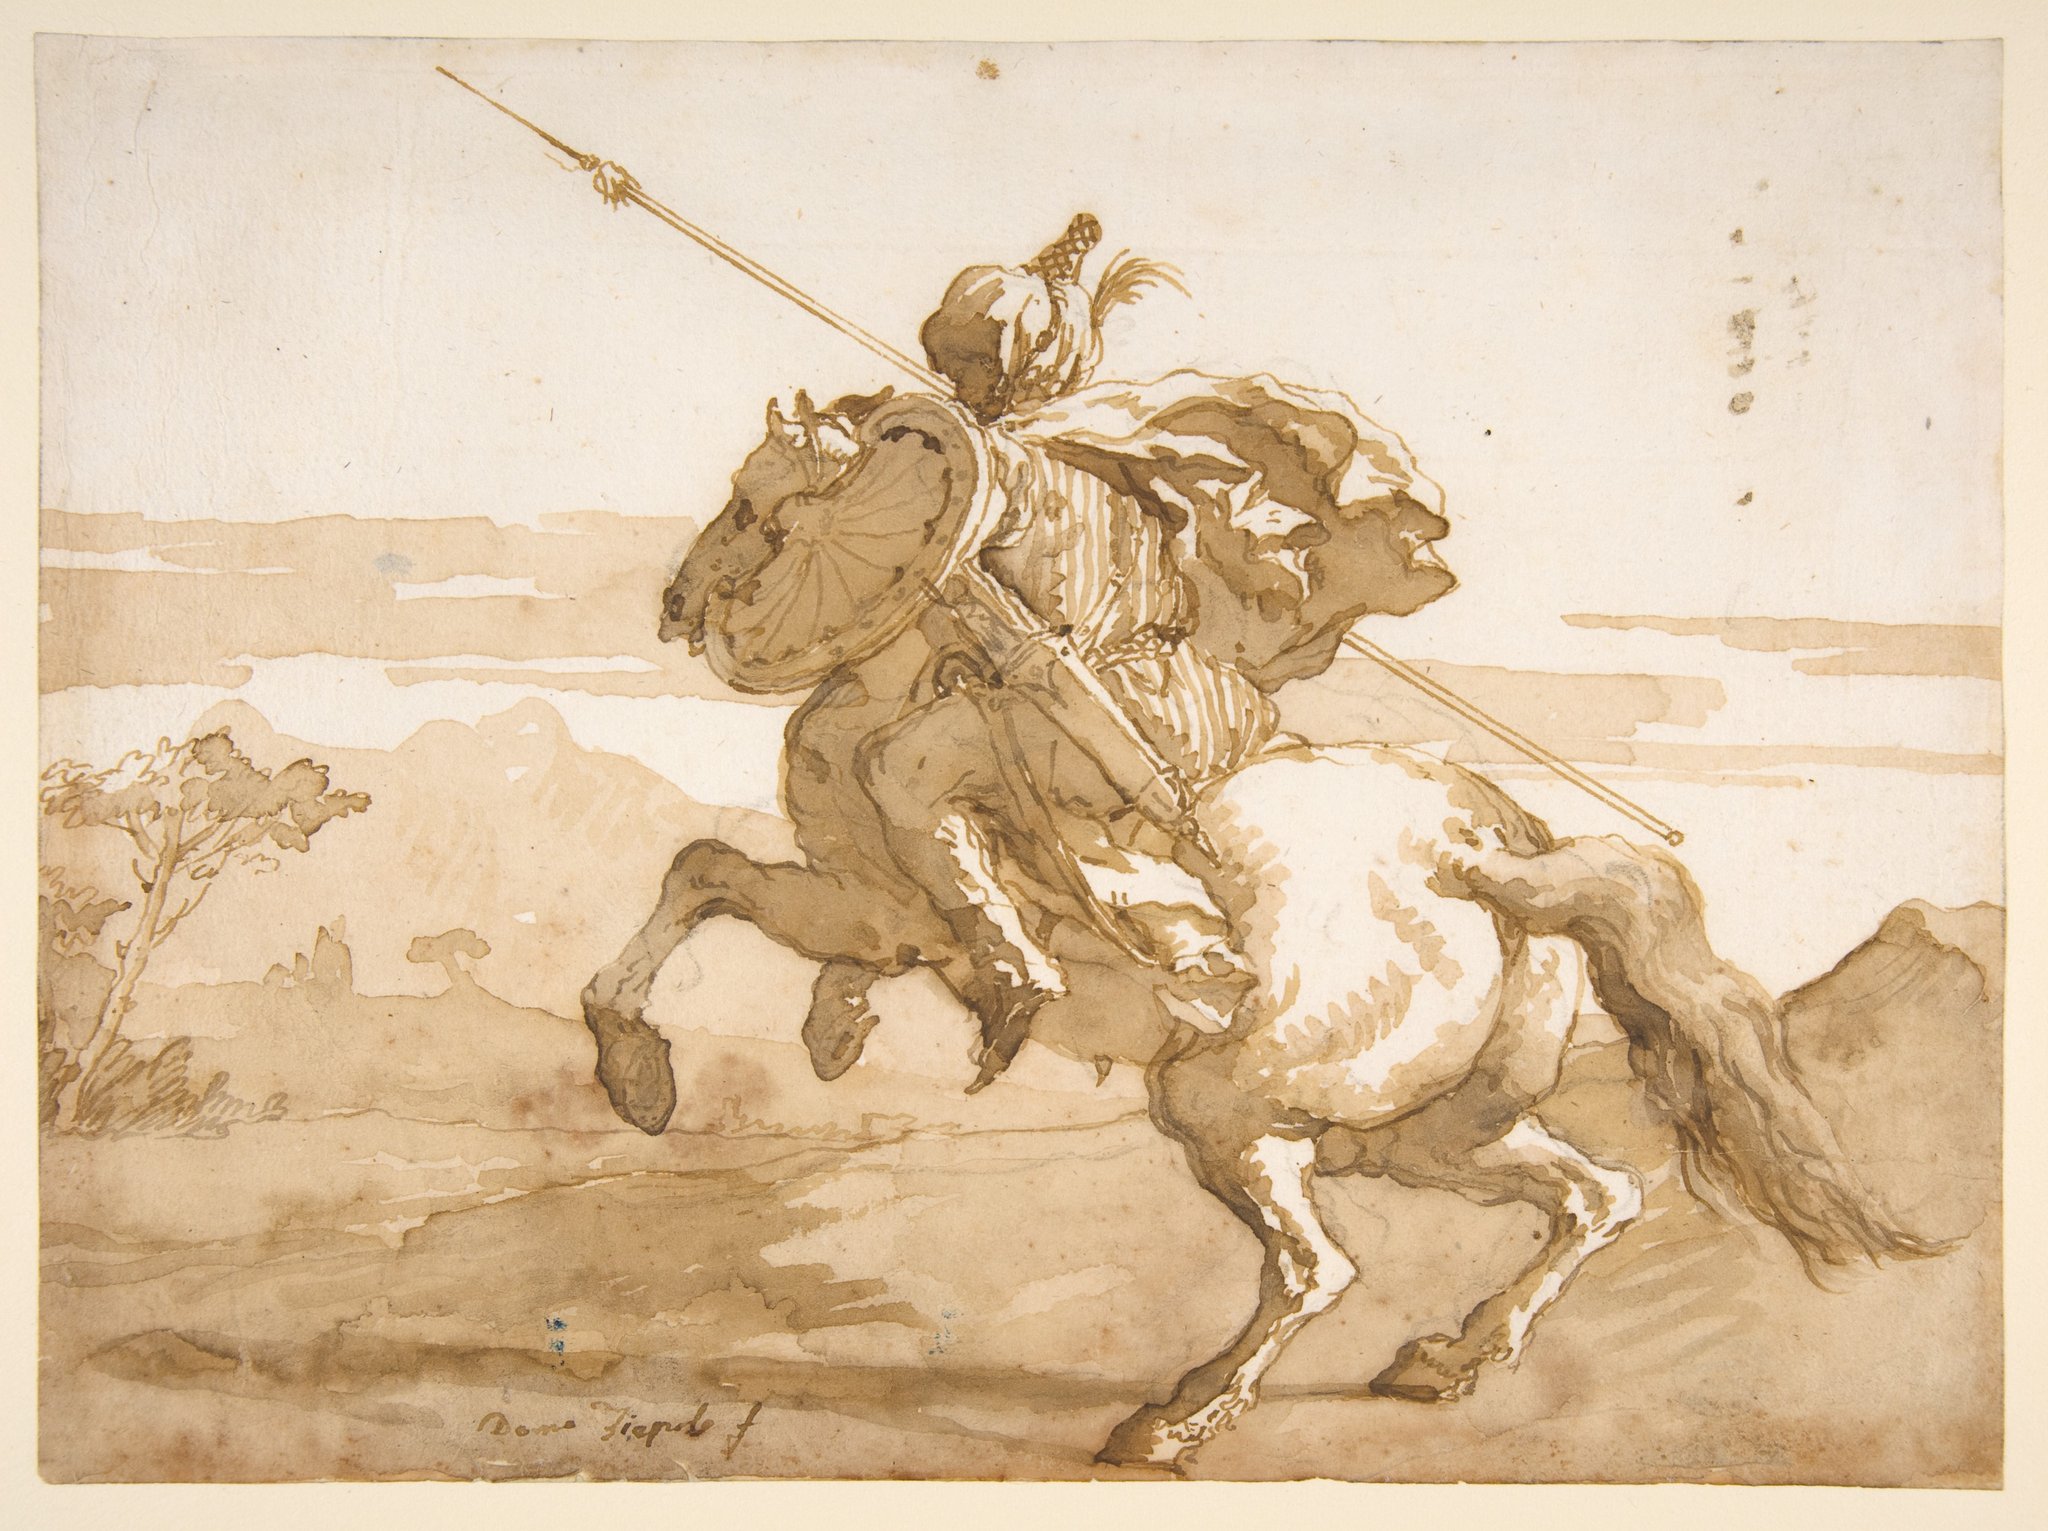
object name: drawing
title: An Oriental Horseman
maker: giovanni domenico tiepolo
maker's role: artist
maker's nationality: italian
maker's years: 1727-1804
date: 1727-1804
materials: chalk, graphite, ink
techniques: brush, pen, wash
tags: shields,spears,men,horses,trees